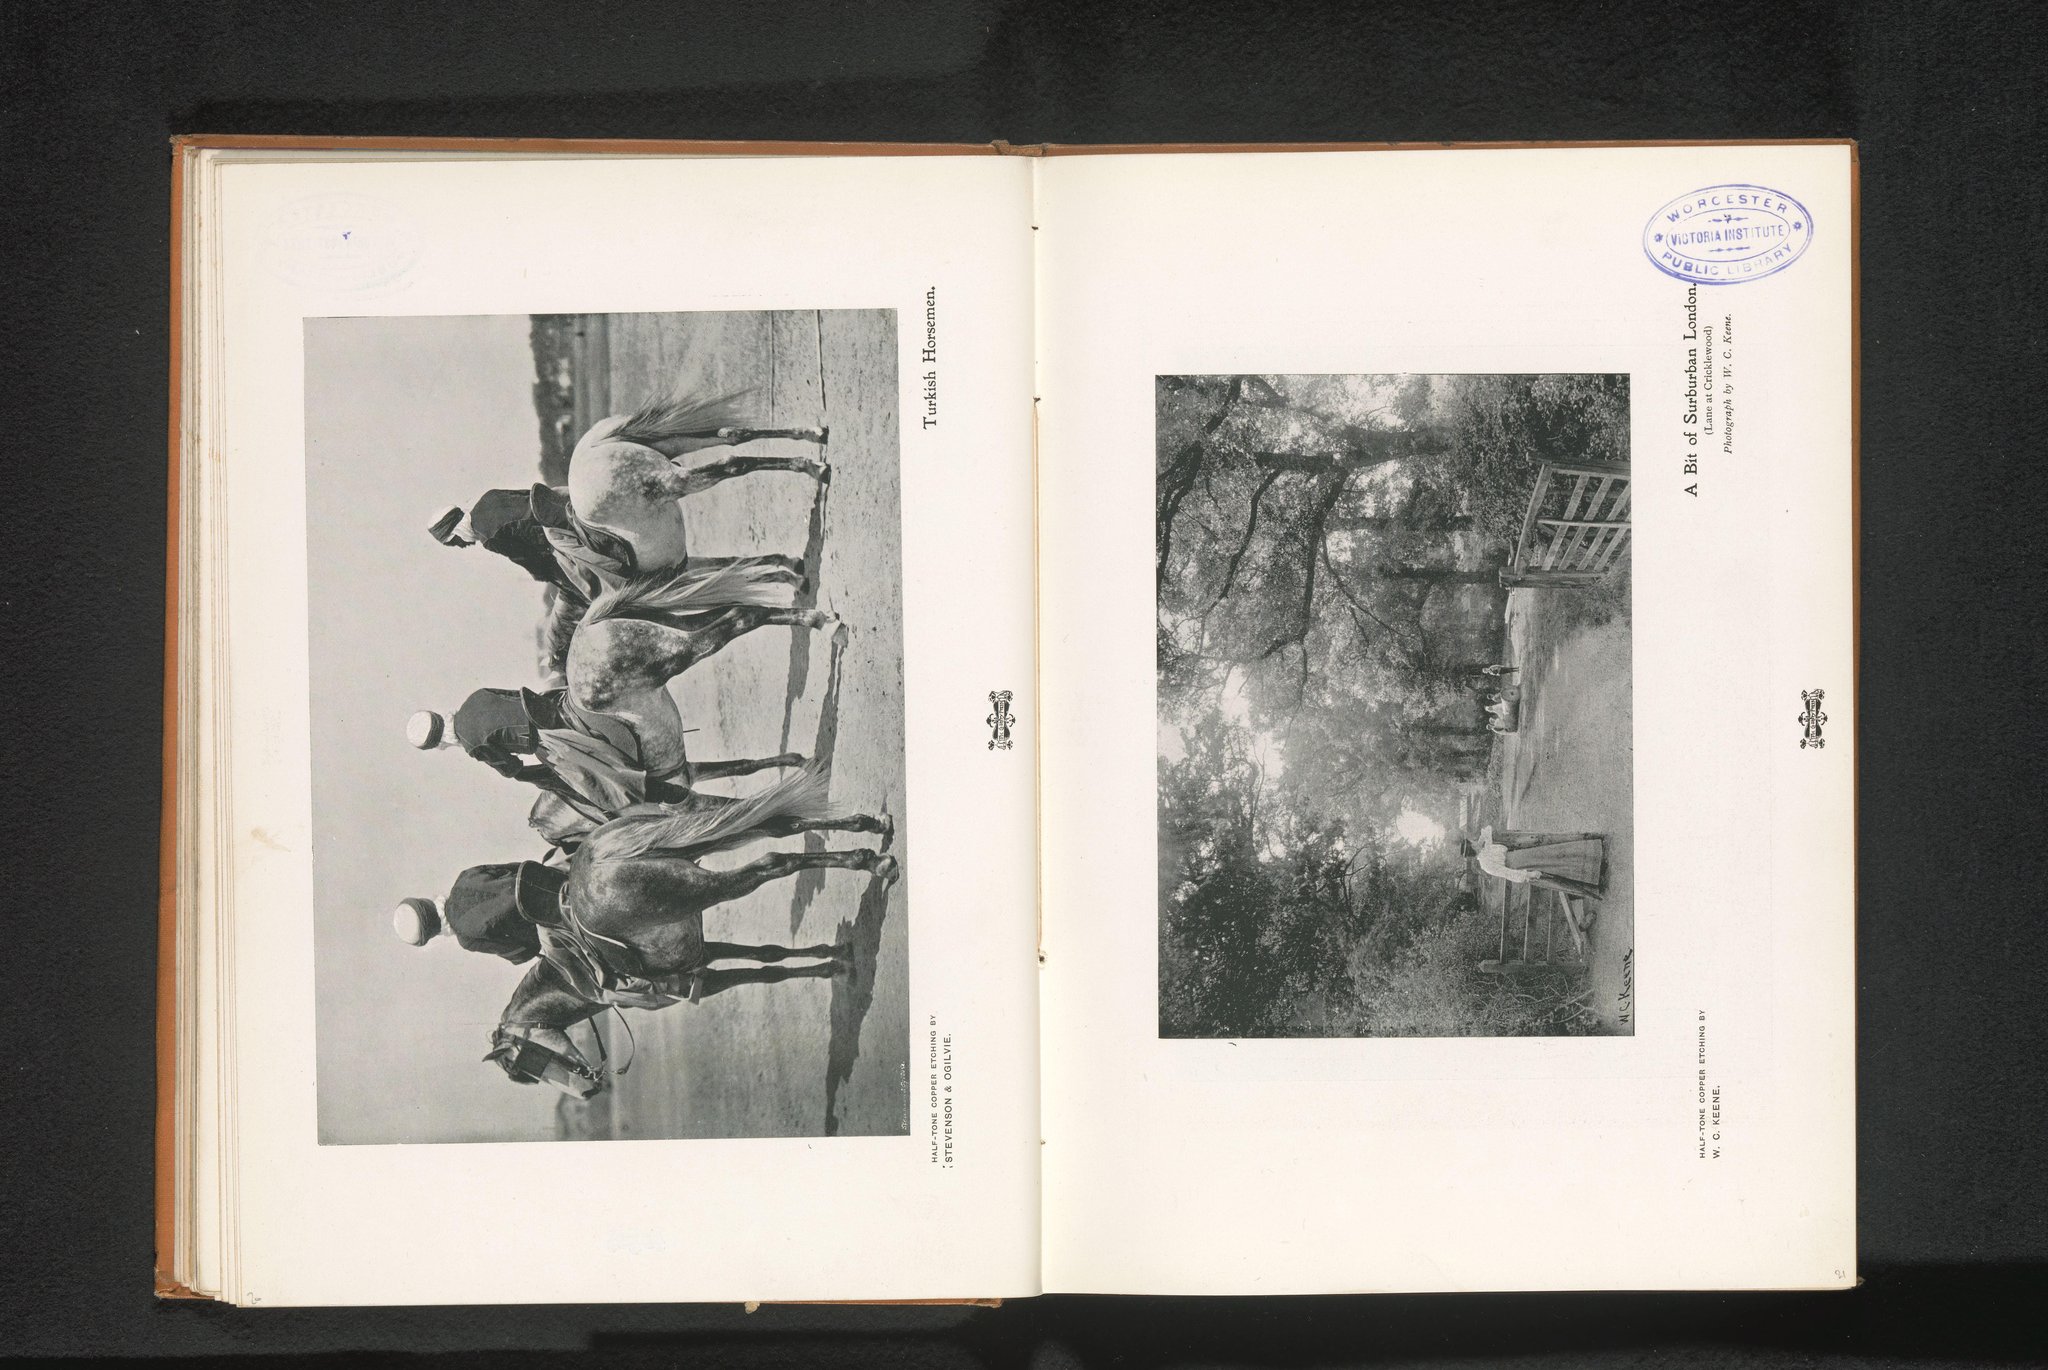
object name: page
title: A bit of surburban London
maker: w.c. keene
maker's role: printer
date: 1894-1899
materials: paper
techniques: autotype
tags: village street (+ city(-scape) with figures, staffage)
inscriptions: collector's mark: ‘Worcester Public Library/ Victoria's Institute’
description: Prent op vijfde ongenummerde pagina na pagina 36.